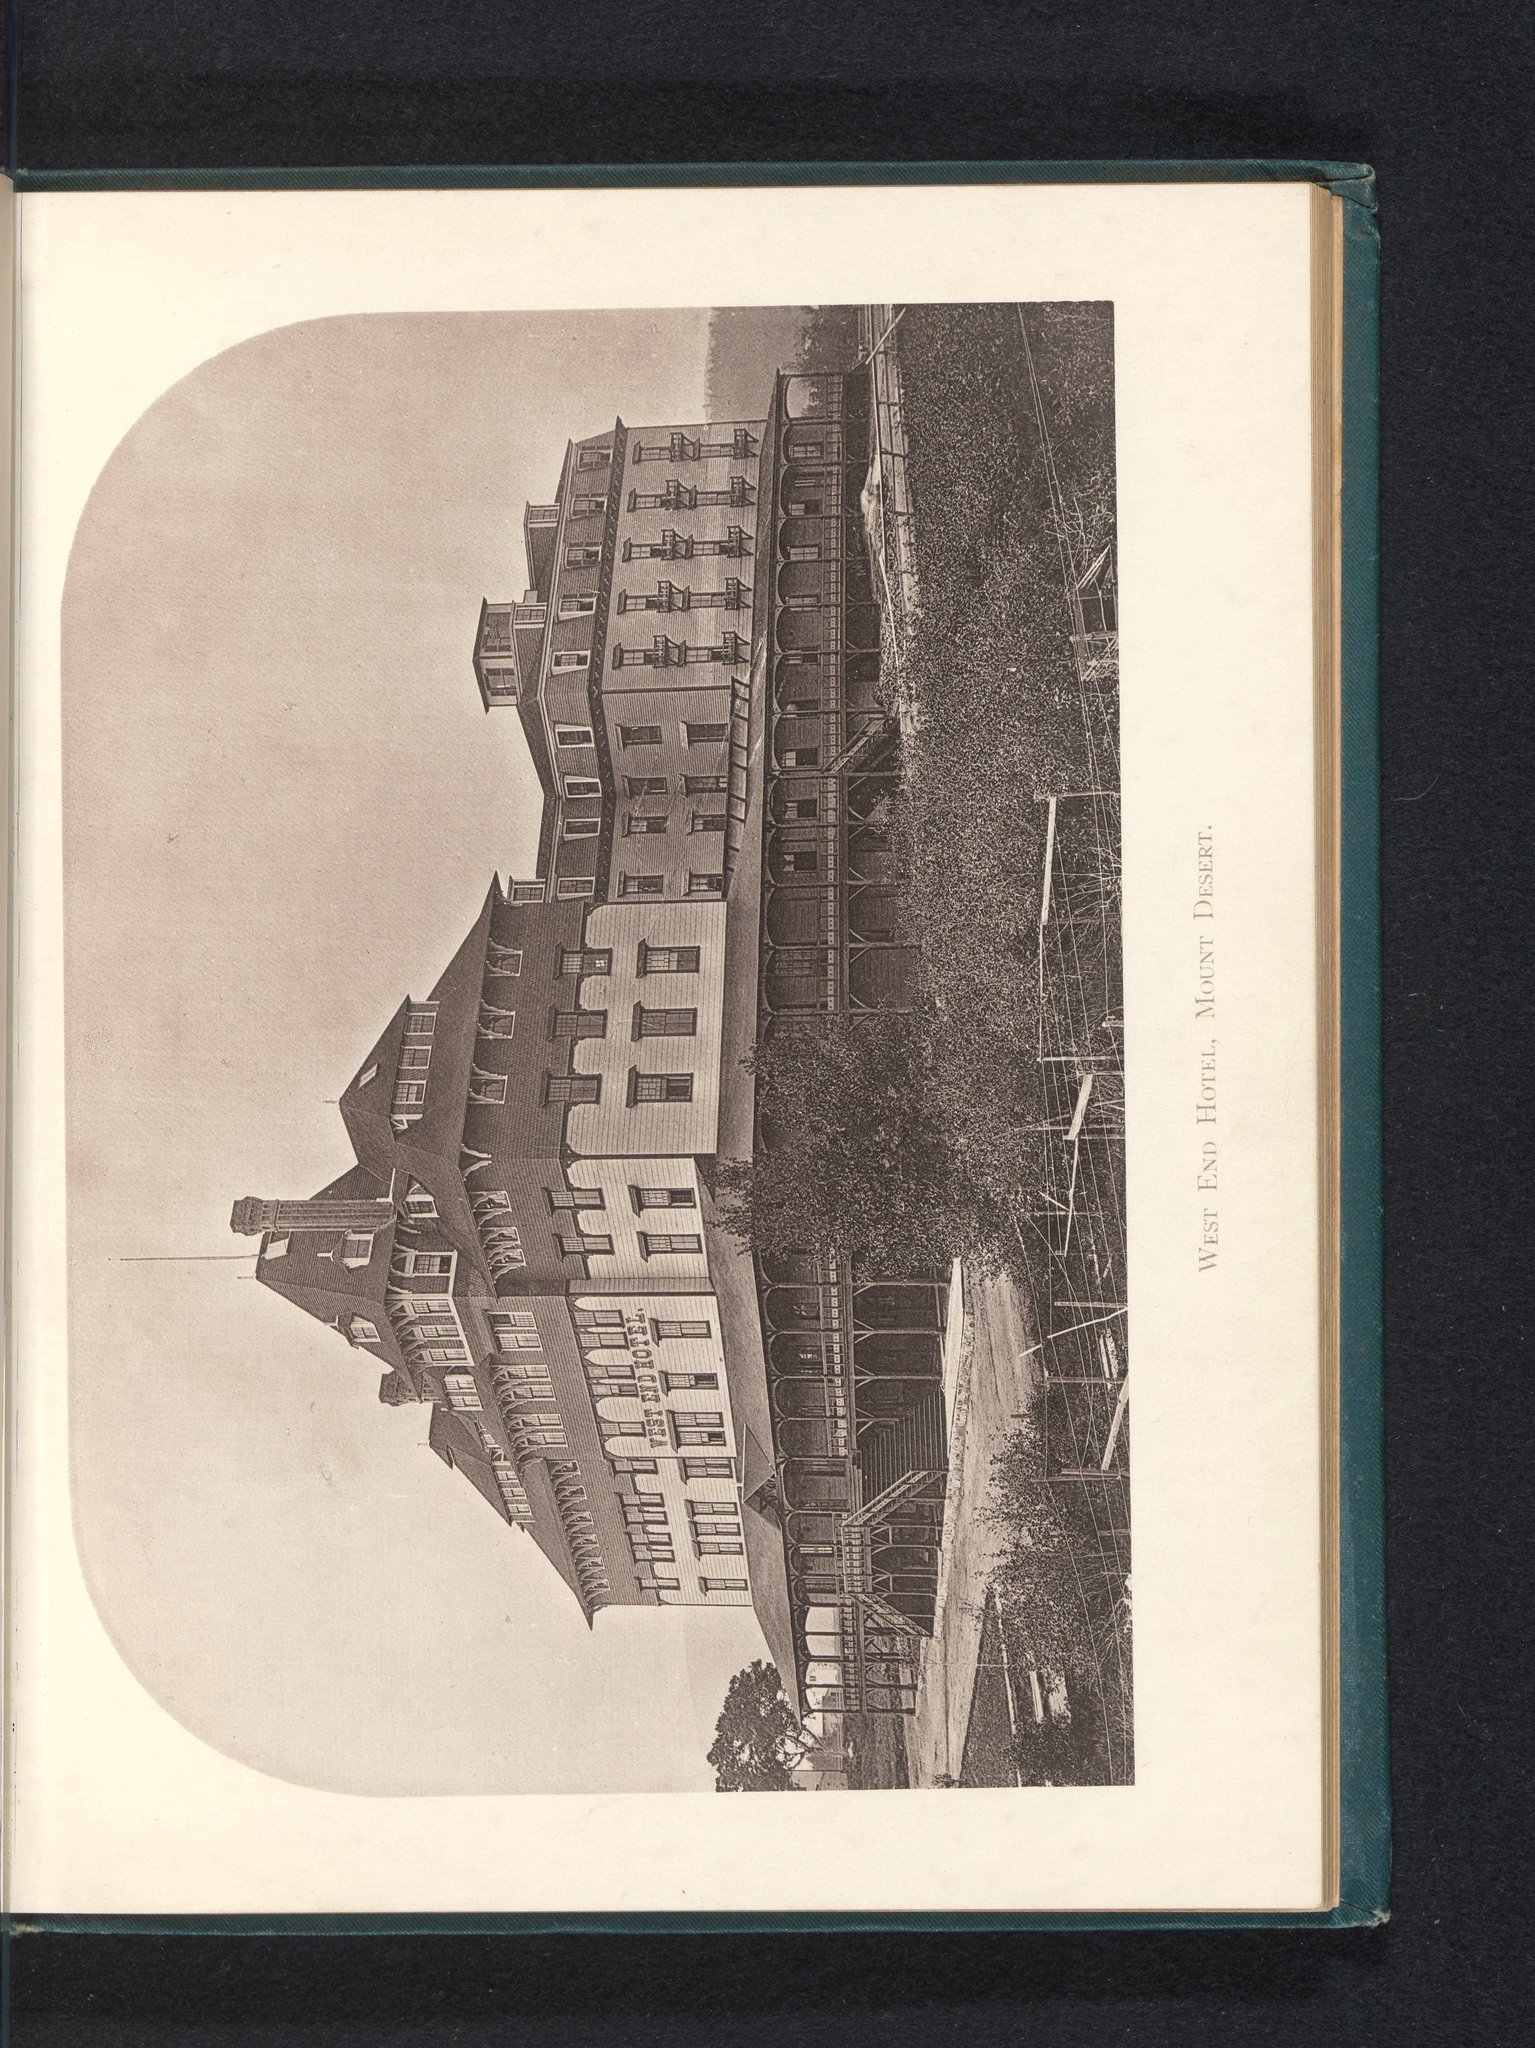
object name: photomechanical print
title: West End Hotel, Mount Desert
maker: Anonymous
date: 1875-1880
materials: paper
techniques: photograph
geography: bar harbor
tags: hotel, hostelry, inn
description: Prent op tweede ongenummerde pagina na pagina 36.